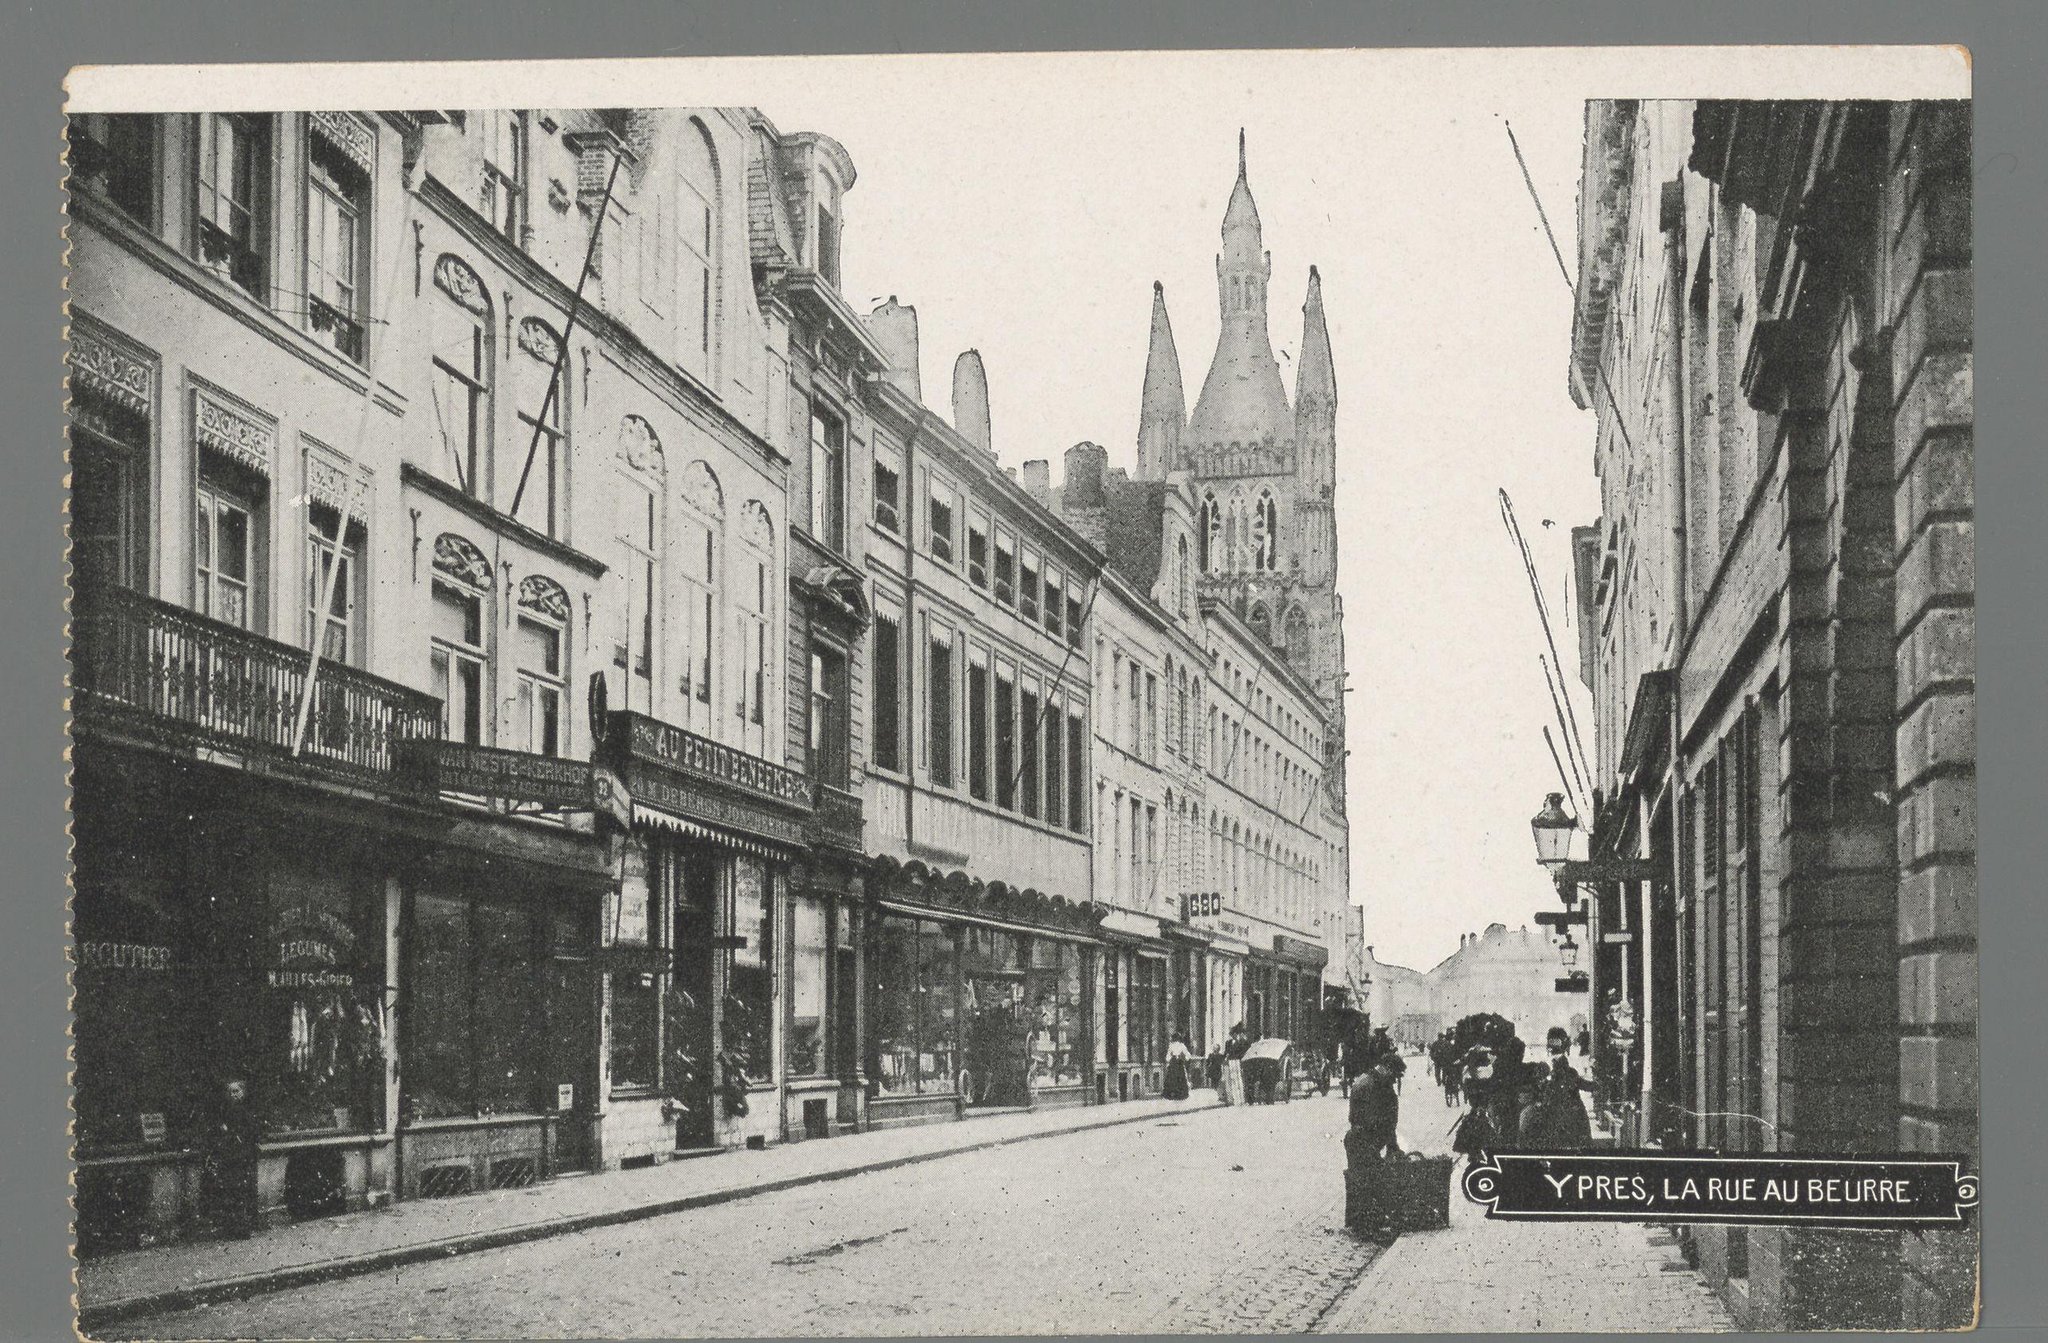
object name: ansichtkaart, prentbriefkaart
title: Ypres, la Rue au Beurre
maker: Anonymous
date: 1906-1918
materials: cardboard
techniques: autotype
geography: ieper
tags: shop, store, street (+ city(-scape) with figures, staffage)